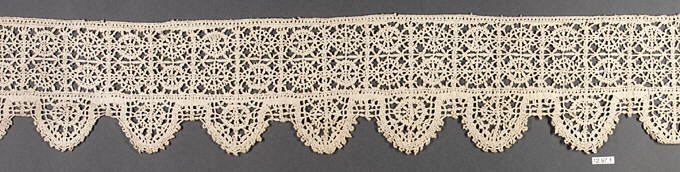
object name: fragment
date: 1601-1700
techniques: lace